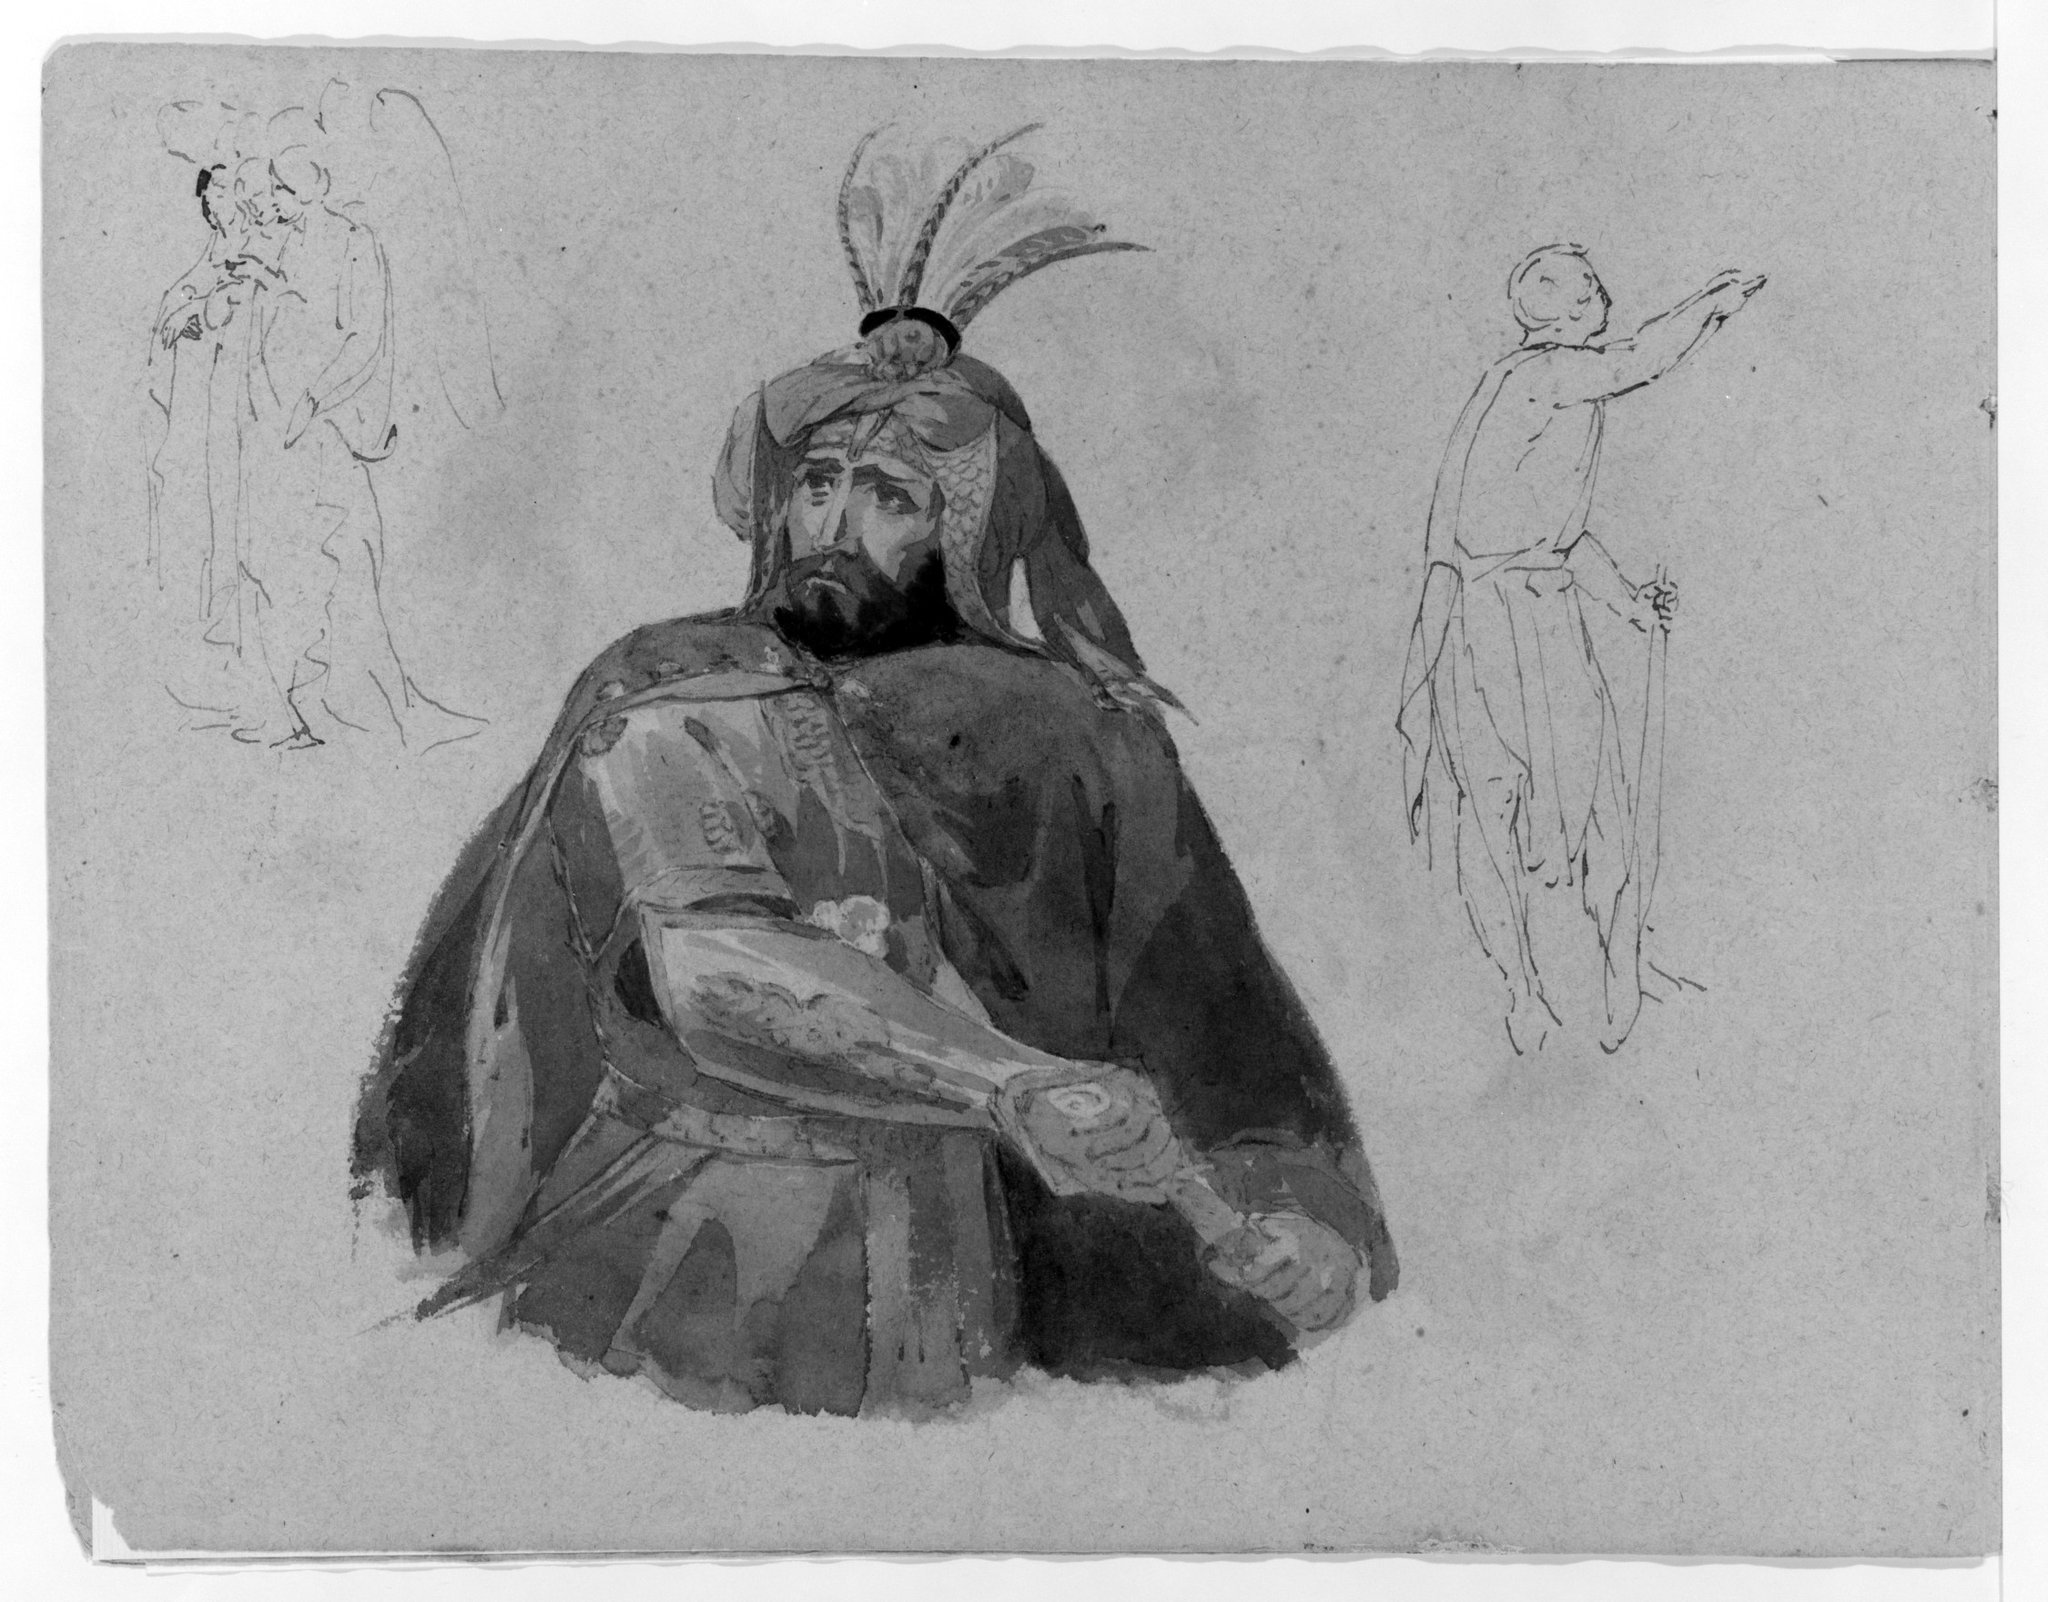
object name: drawing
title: Half-length Bearded Man in Armor and Cape, Drawing Sword (Macbeth?); Three Standing Angels (or Witches?); Male Figure in Skins (from Sketchbook)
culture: american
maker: thomas sully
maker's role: artist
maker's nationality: american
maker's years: 1783-1872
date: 1810-1820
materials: ink, paper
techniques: wash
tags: armor,men,angels